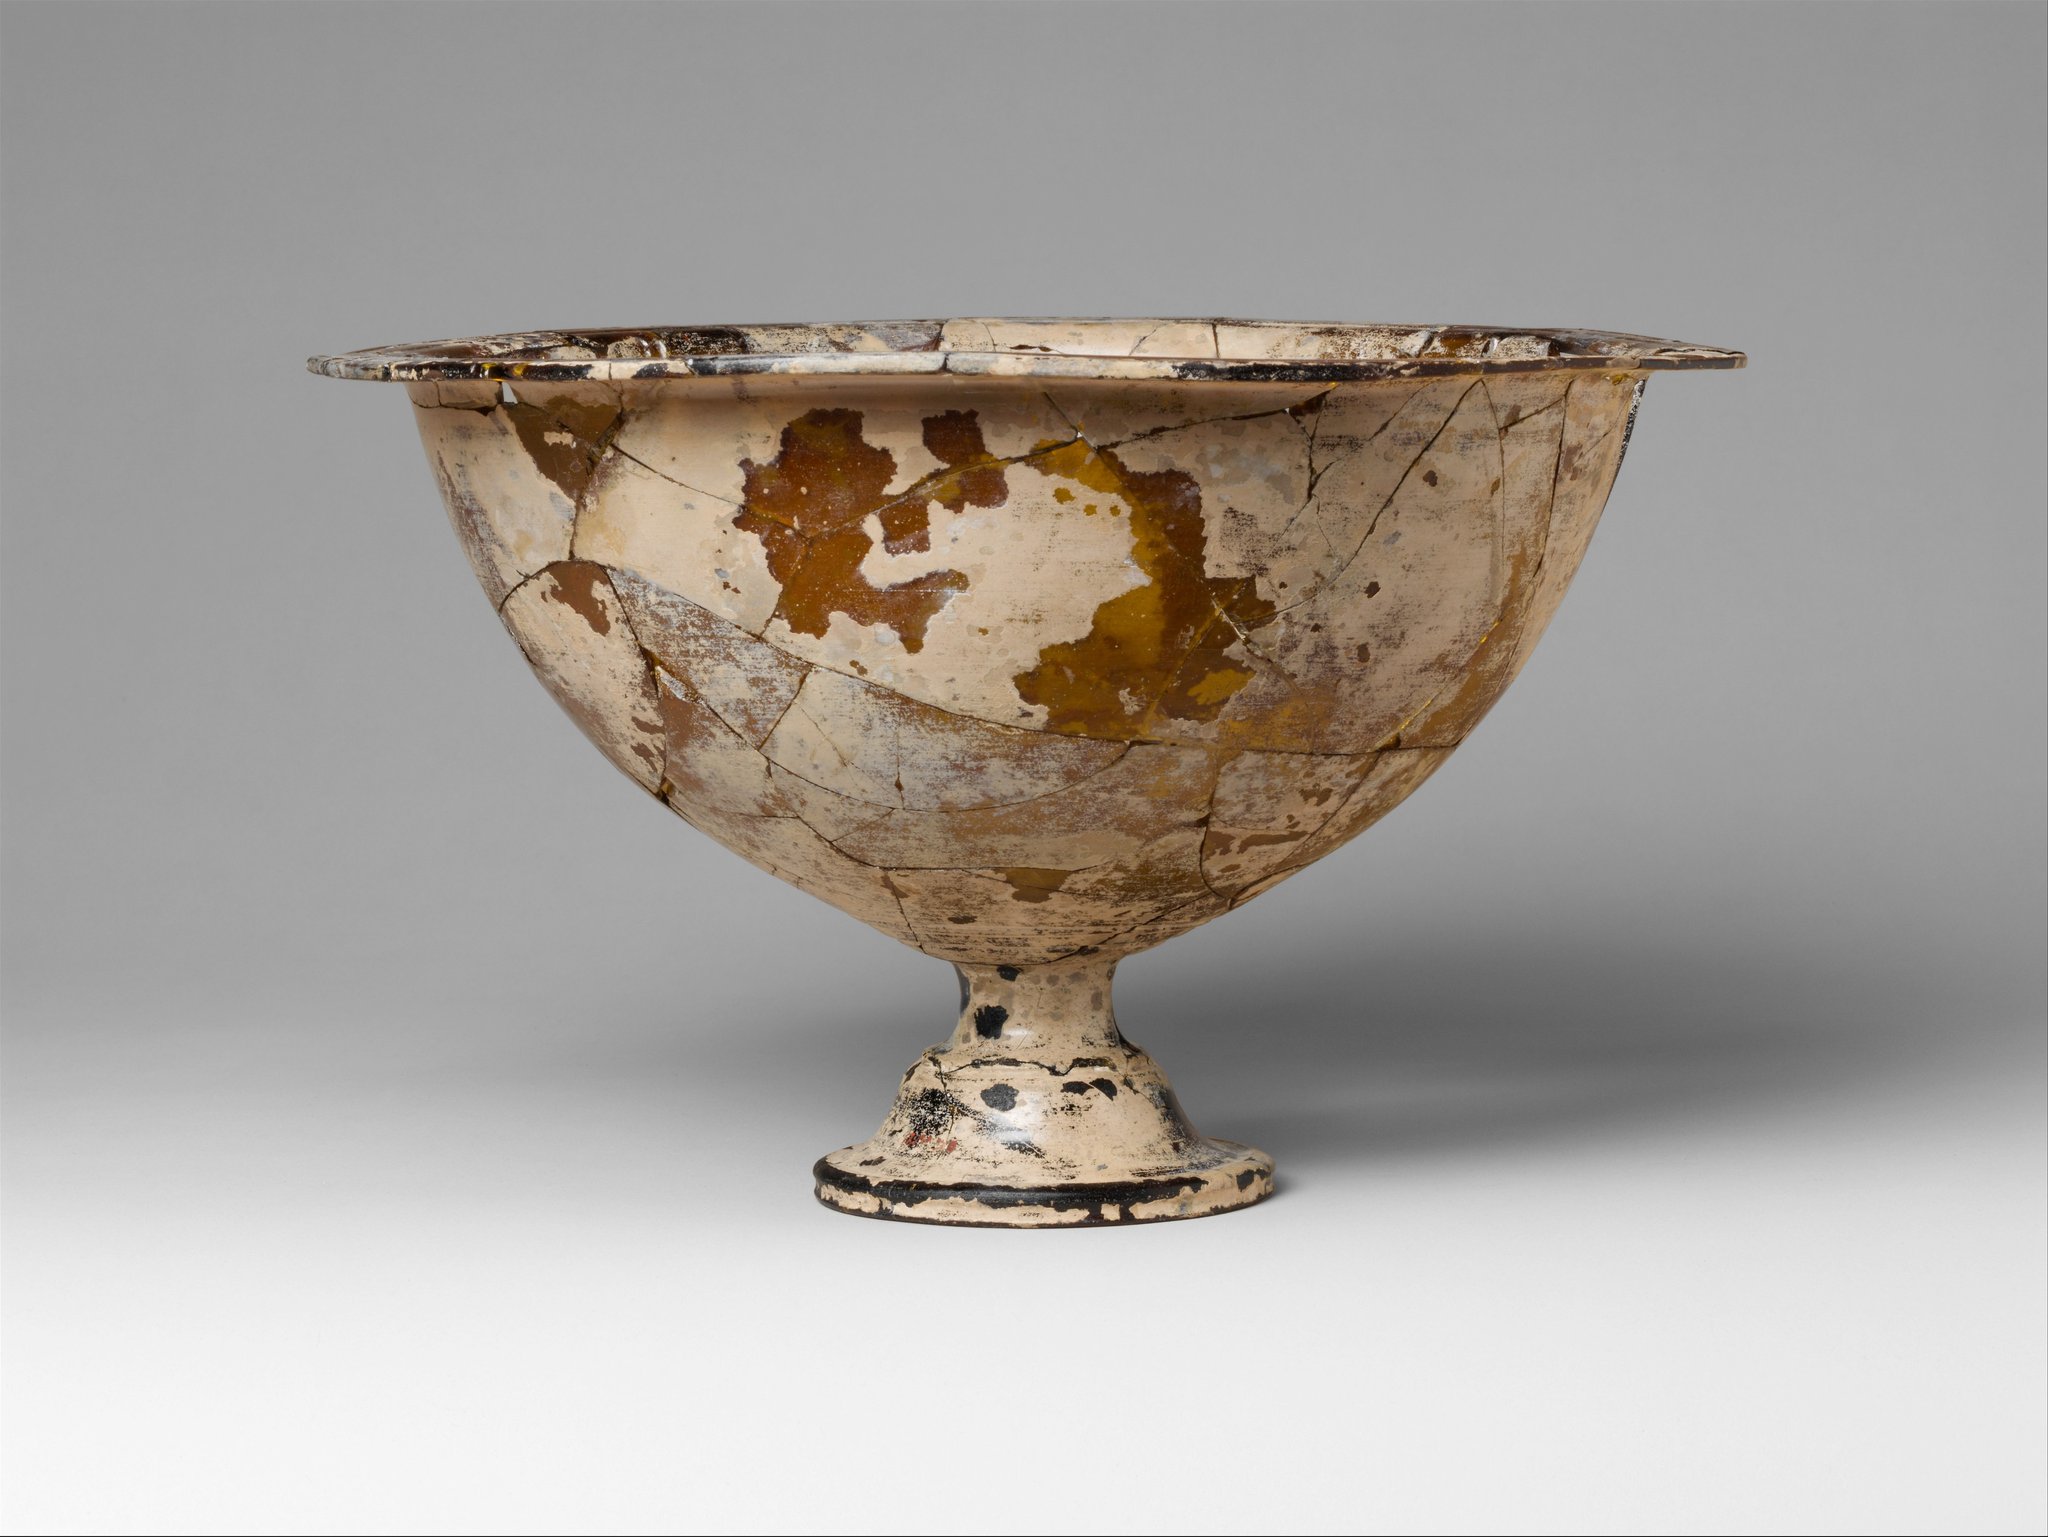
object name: bowl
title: Glass krater (mixing bowl)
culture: greek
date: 200-1 BCE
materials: glass